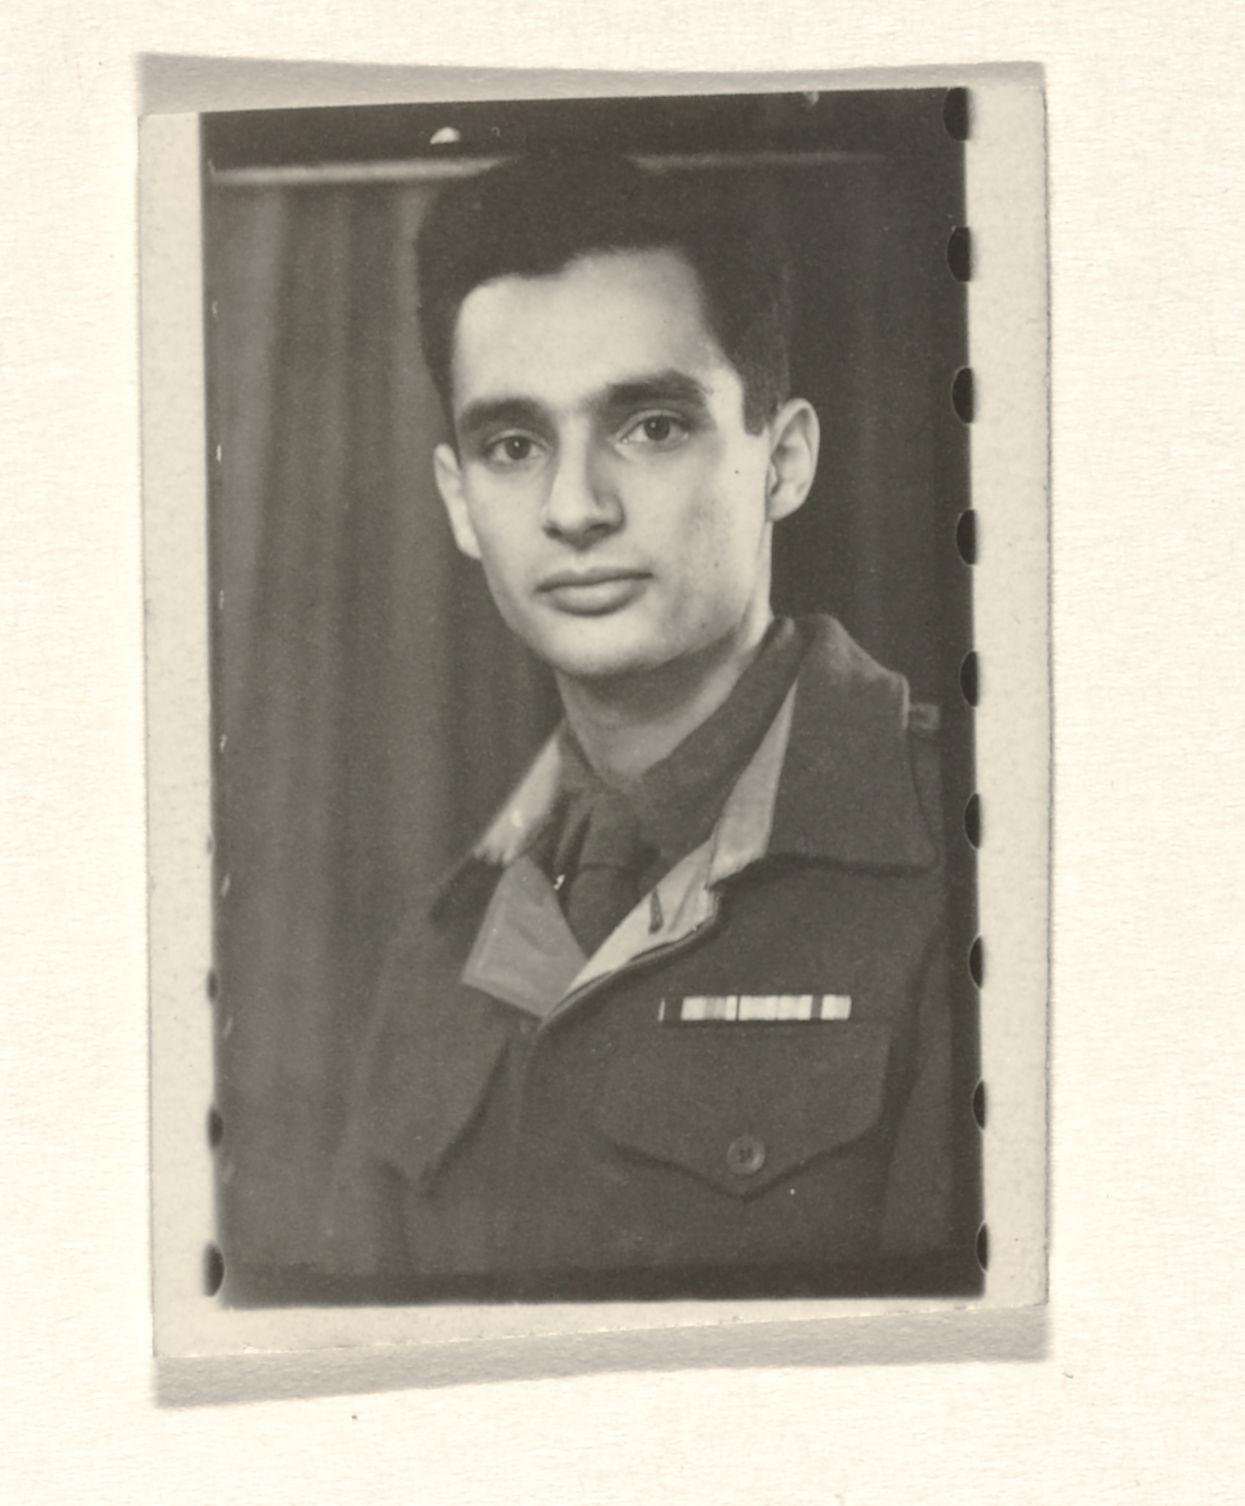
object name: photograph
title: Karl-Heinz Arndtheim, de tweede echtgenoot van Isabel Wachenheimer, in militair uniform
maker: Anonymous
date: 1944-1955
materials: photographic support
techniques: gelatin silver print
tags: karl-heinz arndtheim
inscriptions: number: ‘6 wz’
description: Karl-Heinz Arndtheim, de tweede echtgenoot van Isabel Wachenheimer, in militair uniform.